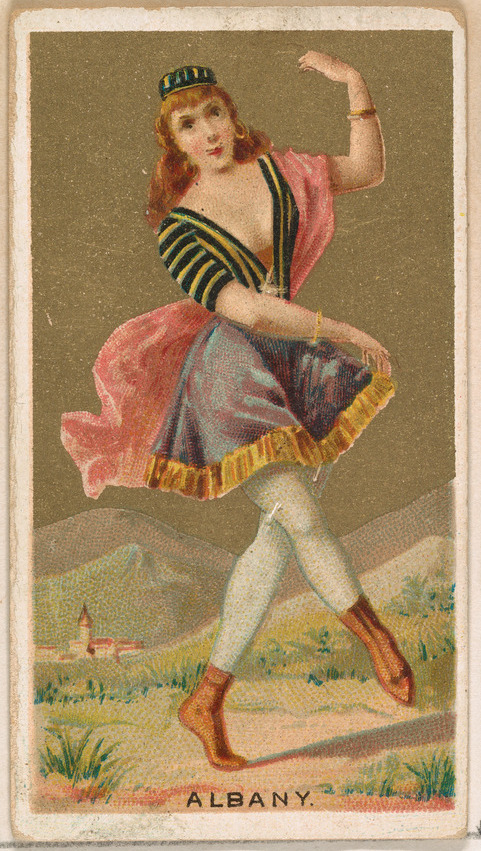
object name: print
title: Albany, from the Dancing Girls of the World series (N185) issued by Wm. S. Kimball & Co.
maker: william s. kimball & company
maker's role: publisher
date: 1889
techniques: color lithograph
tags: girls,dancing